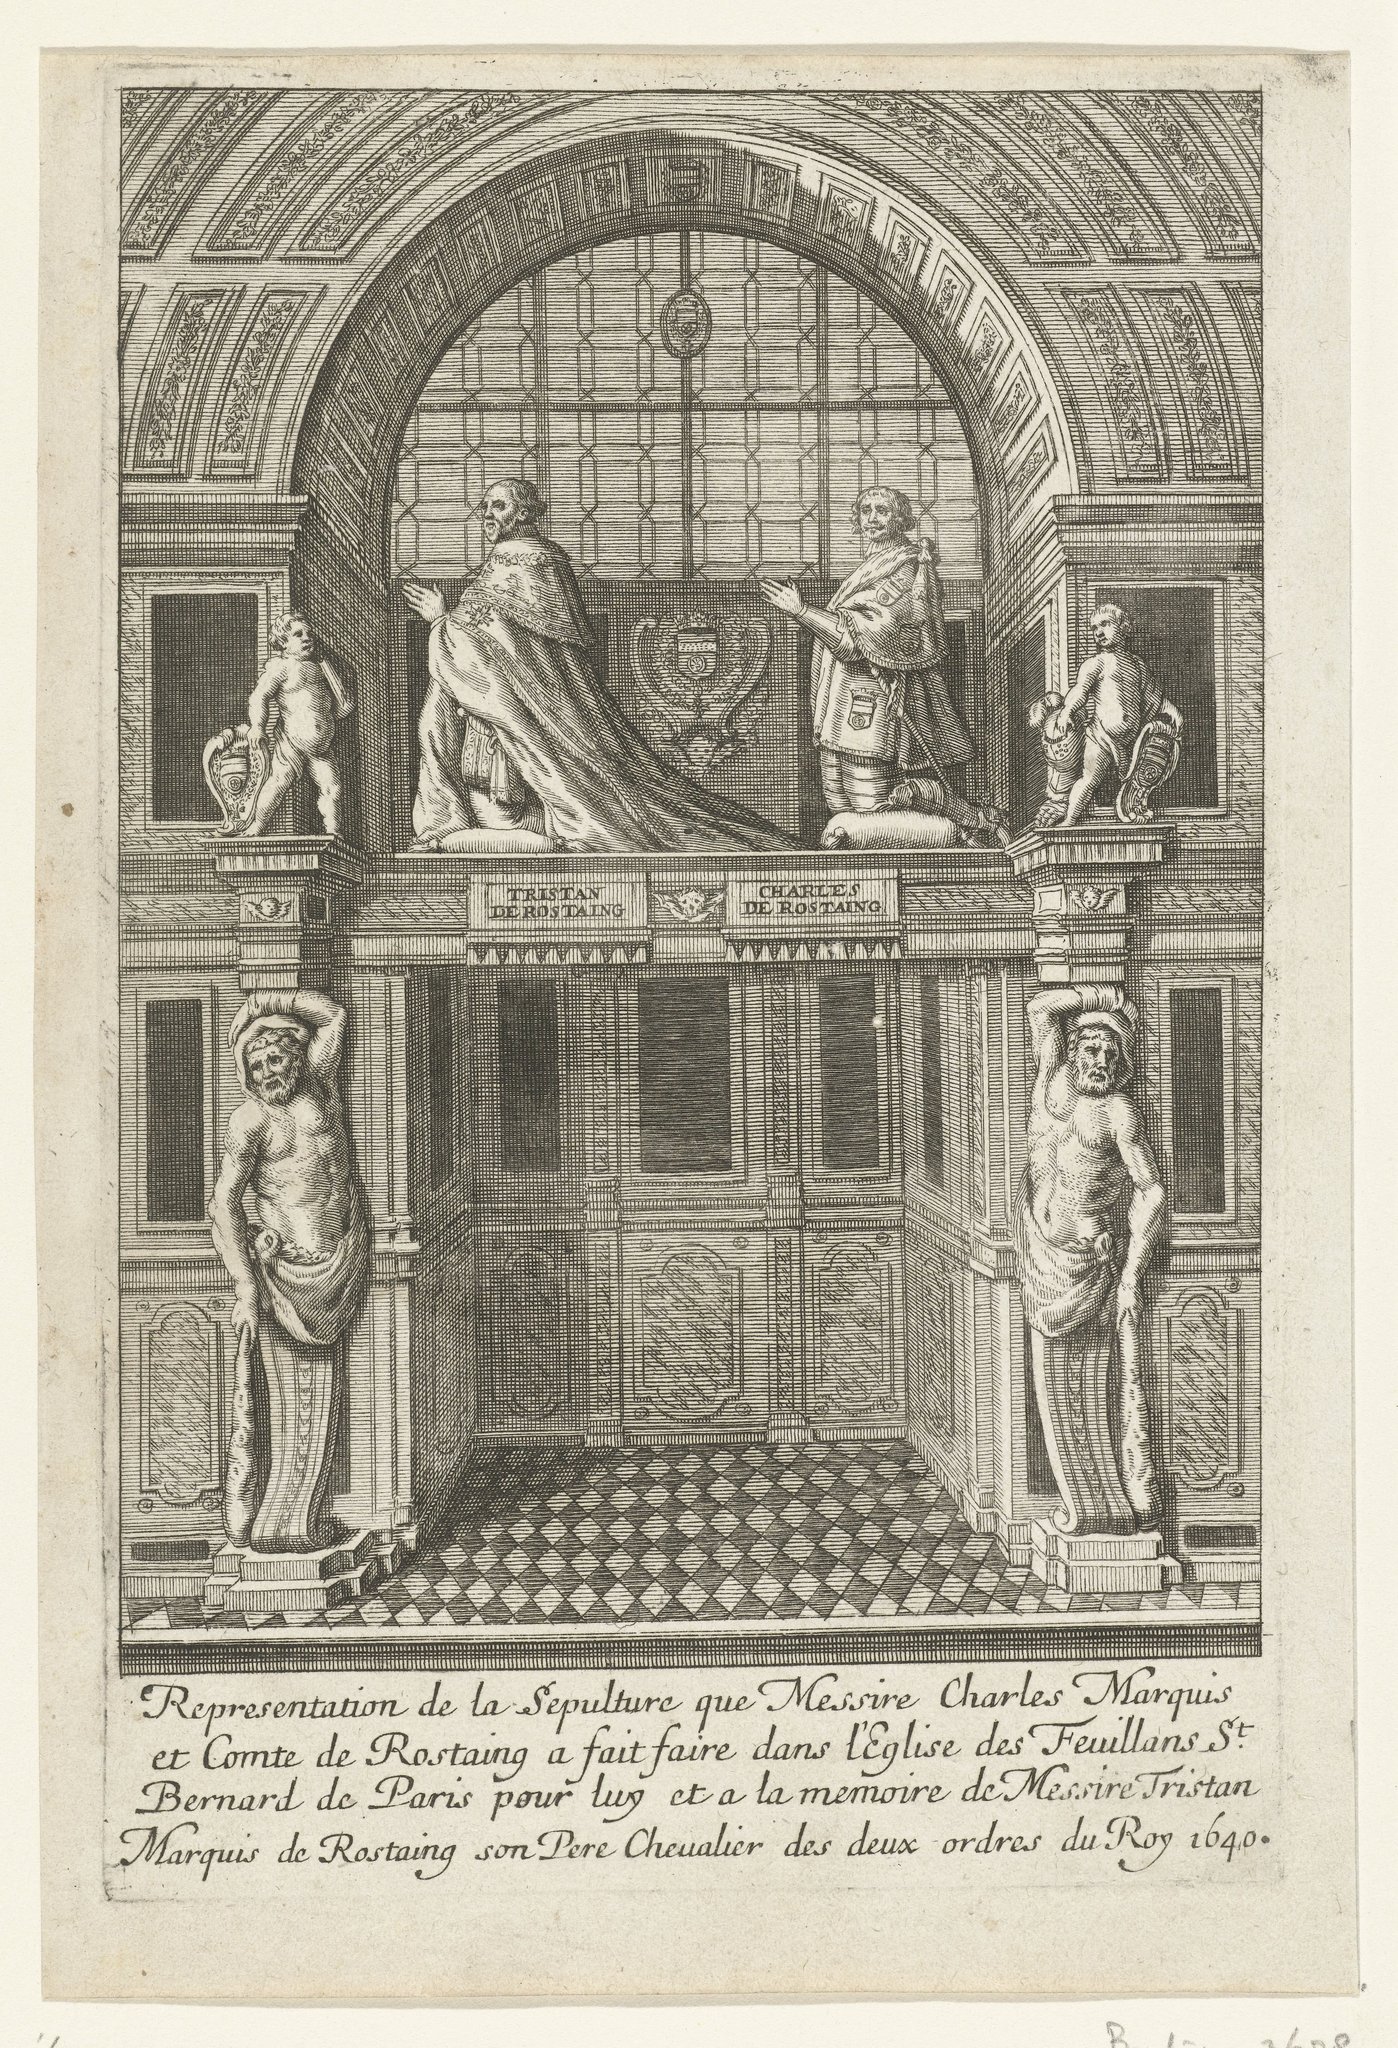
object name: ornament print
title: Grafkapel van de familie Rostaing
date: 1629-1654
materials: paper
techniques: engraving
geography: france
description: Op de kroonlijst aan de voorkant knielen Tristan en Charles de Rostaing, onderaan staan vier regels tekst. De grafkapel staat in de kerk van de Feuillants in Parijs.